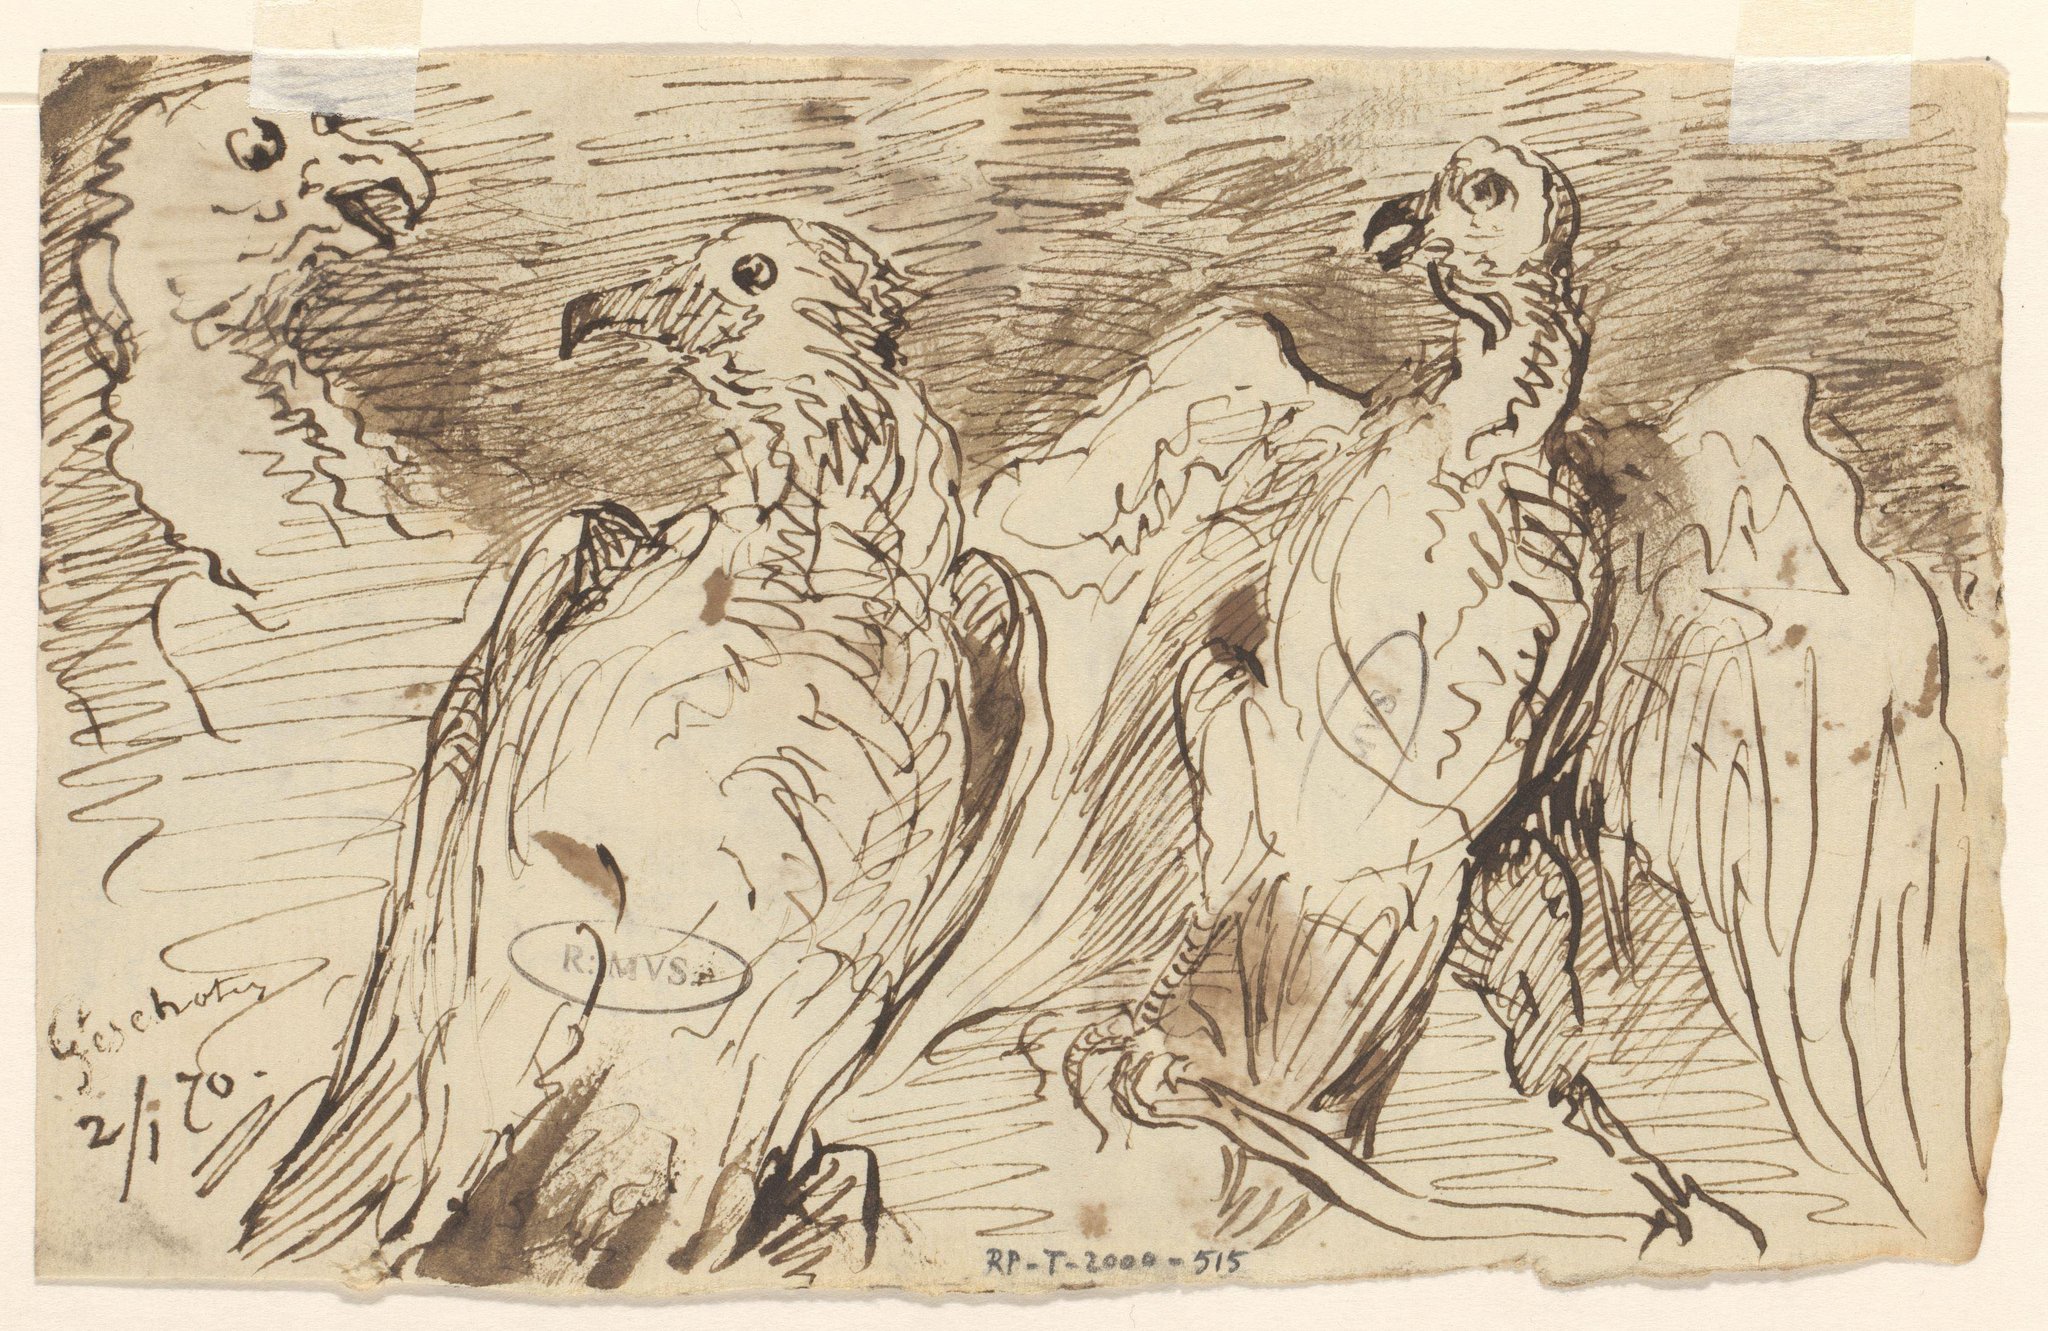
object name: drawing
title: Drie roofvogels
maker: johannes tavenraat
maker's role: draughtsman, painter, print maker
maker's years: 1809-1881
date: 1870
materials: ink, paper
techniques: brush, pen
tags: predatory birds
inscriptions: collector's mark: Lugt 2228, date: ‘2/1 70.’